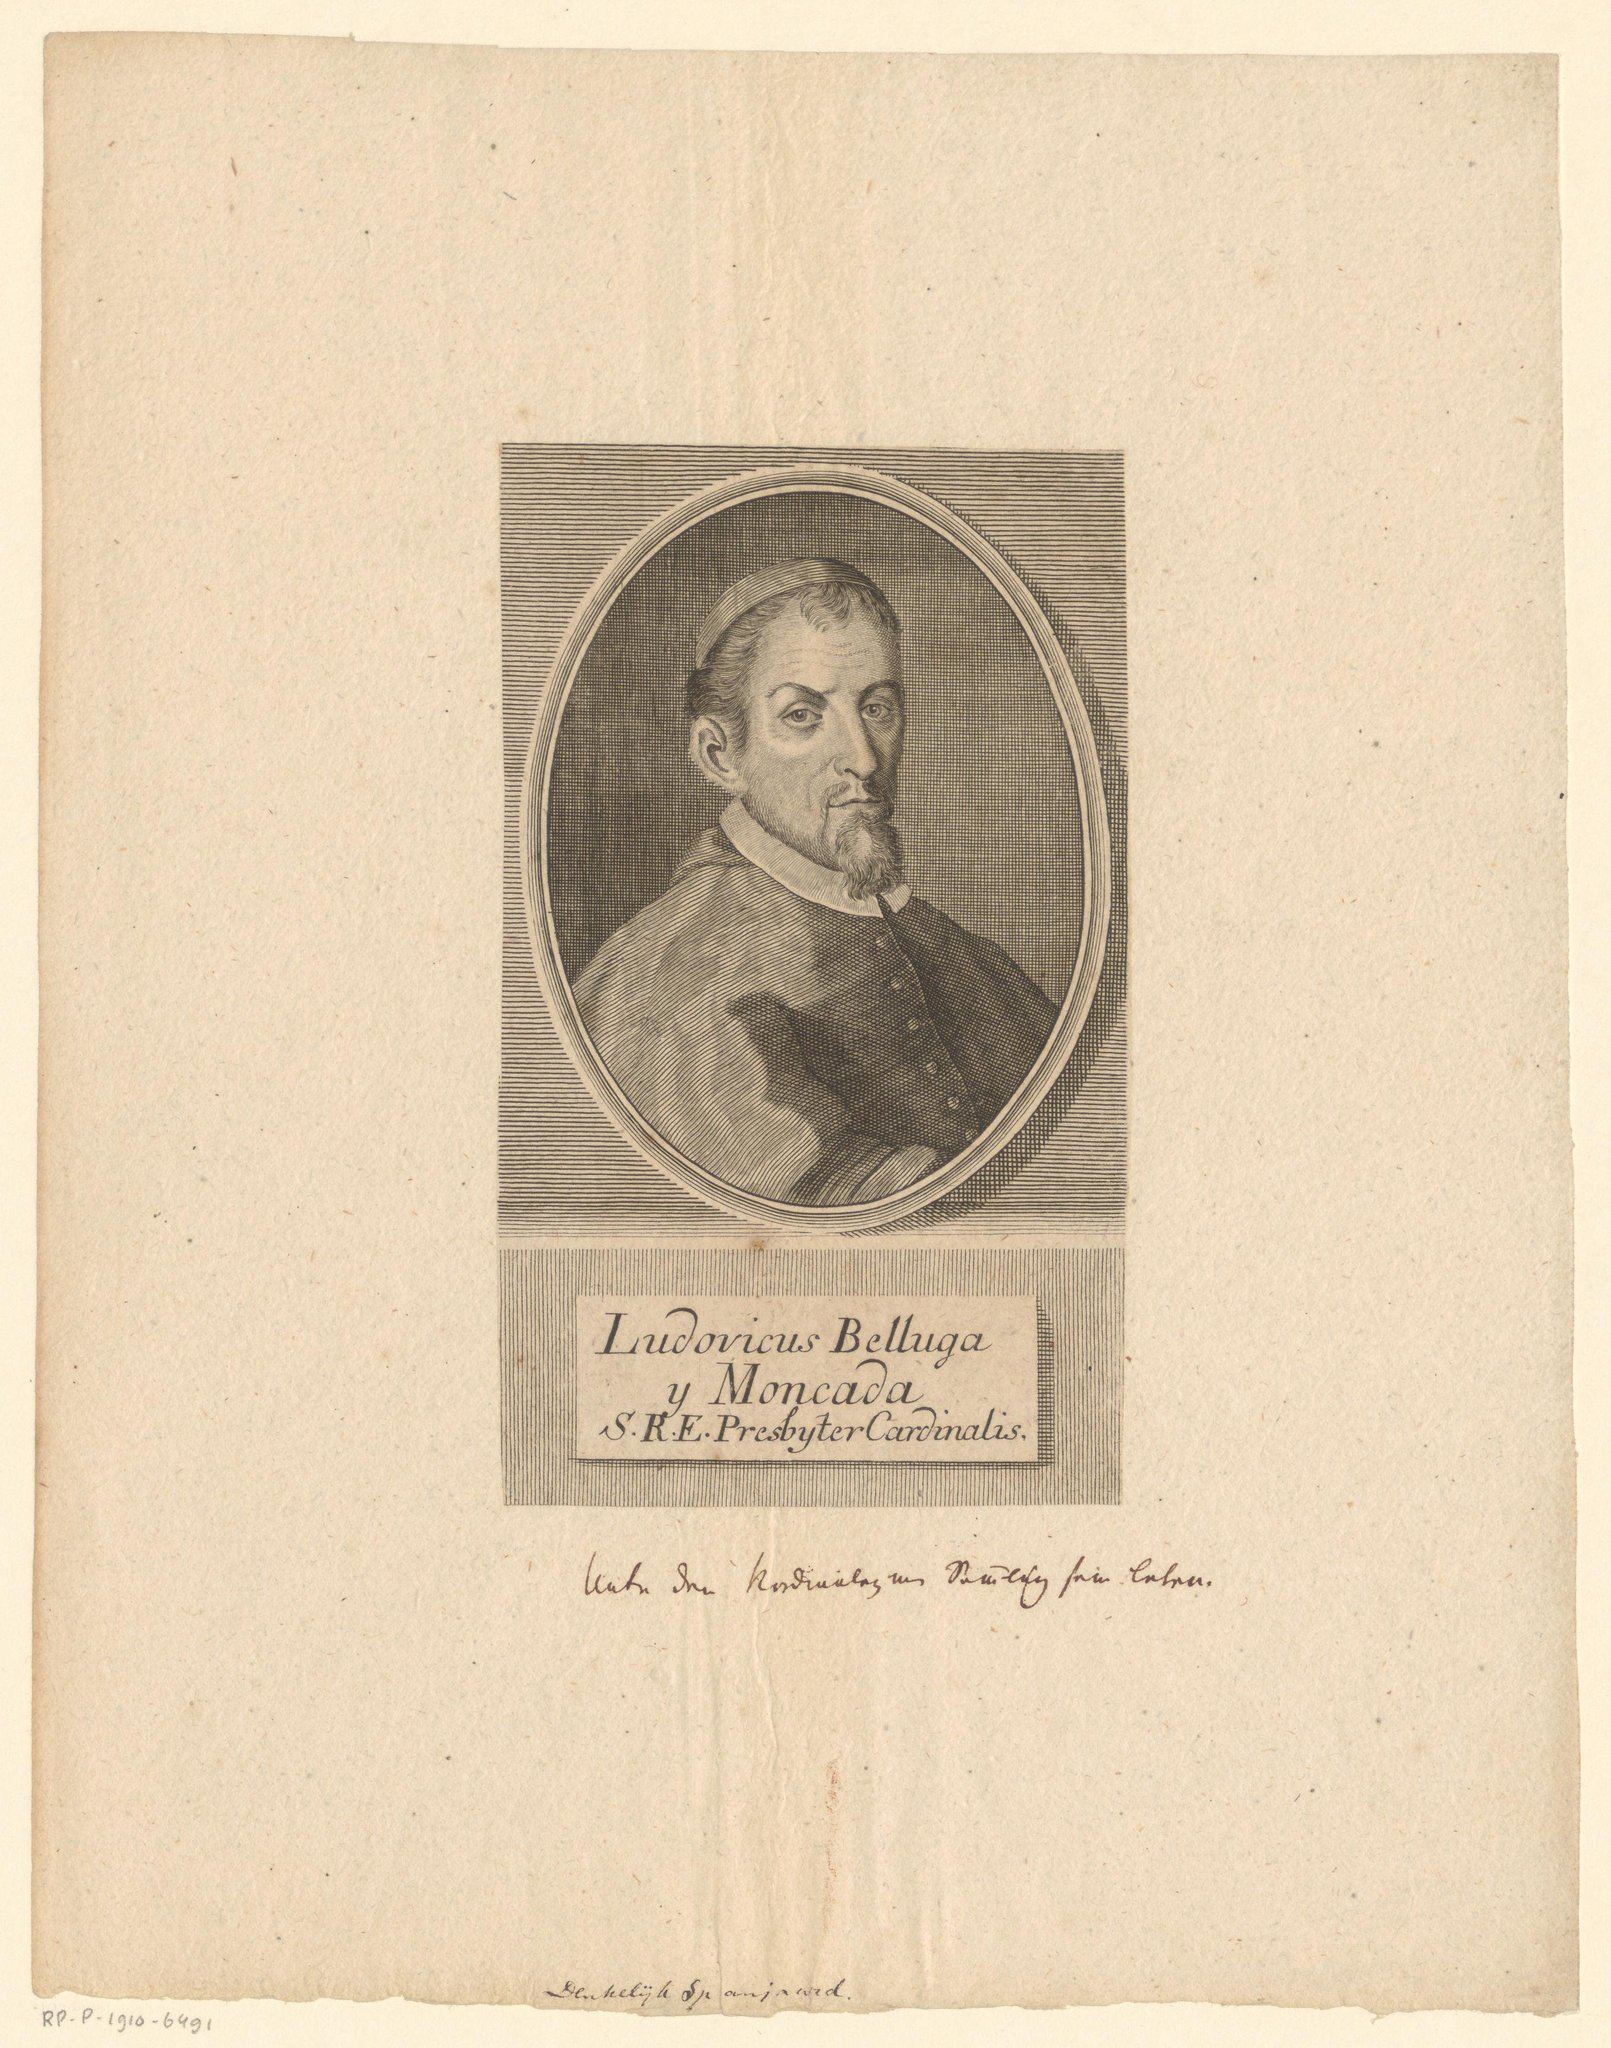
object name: print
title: Portret van Luis Antonio Belluga y Moncada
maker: johann martin bernigeroth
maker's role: print maker, publisher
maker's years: 1713-1767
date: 1736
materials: paper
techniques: engraving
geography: leipzig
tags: clergyman, historical persons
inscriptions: collector's mark: Lugt 2228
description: Prent ook gebruikt in: Die Neue Europäische Fama, Welche den gegenwärtigen Zustand der vornehmsten Höfe entdecket. dl. 13. Leipzig: Gleditsch, 1736.